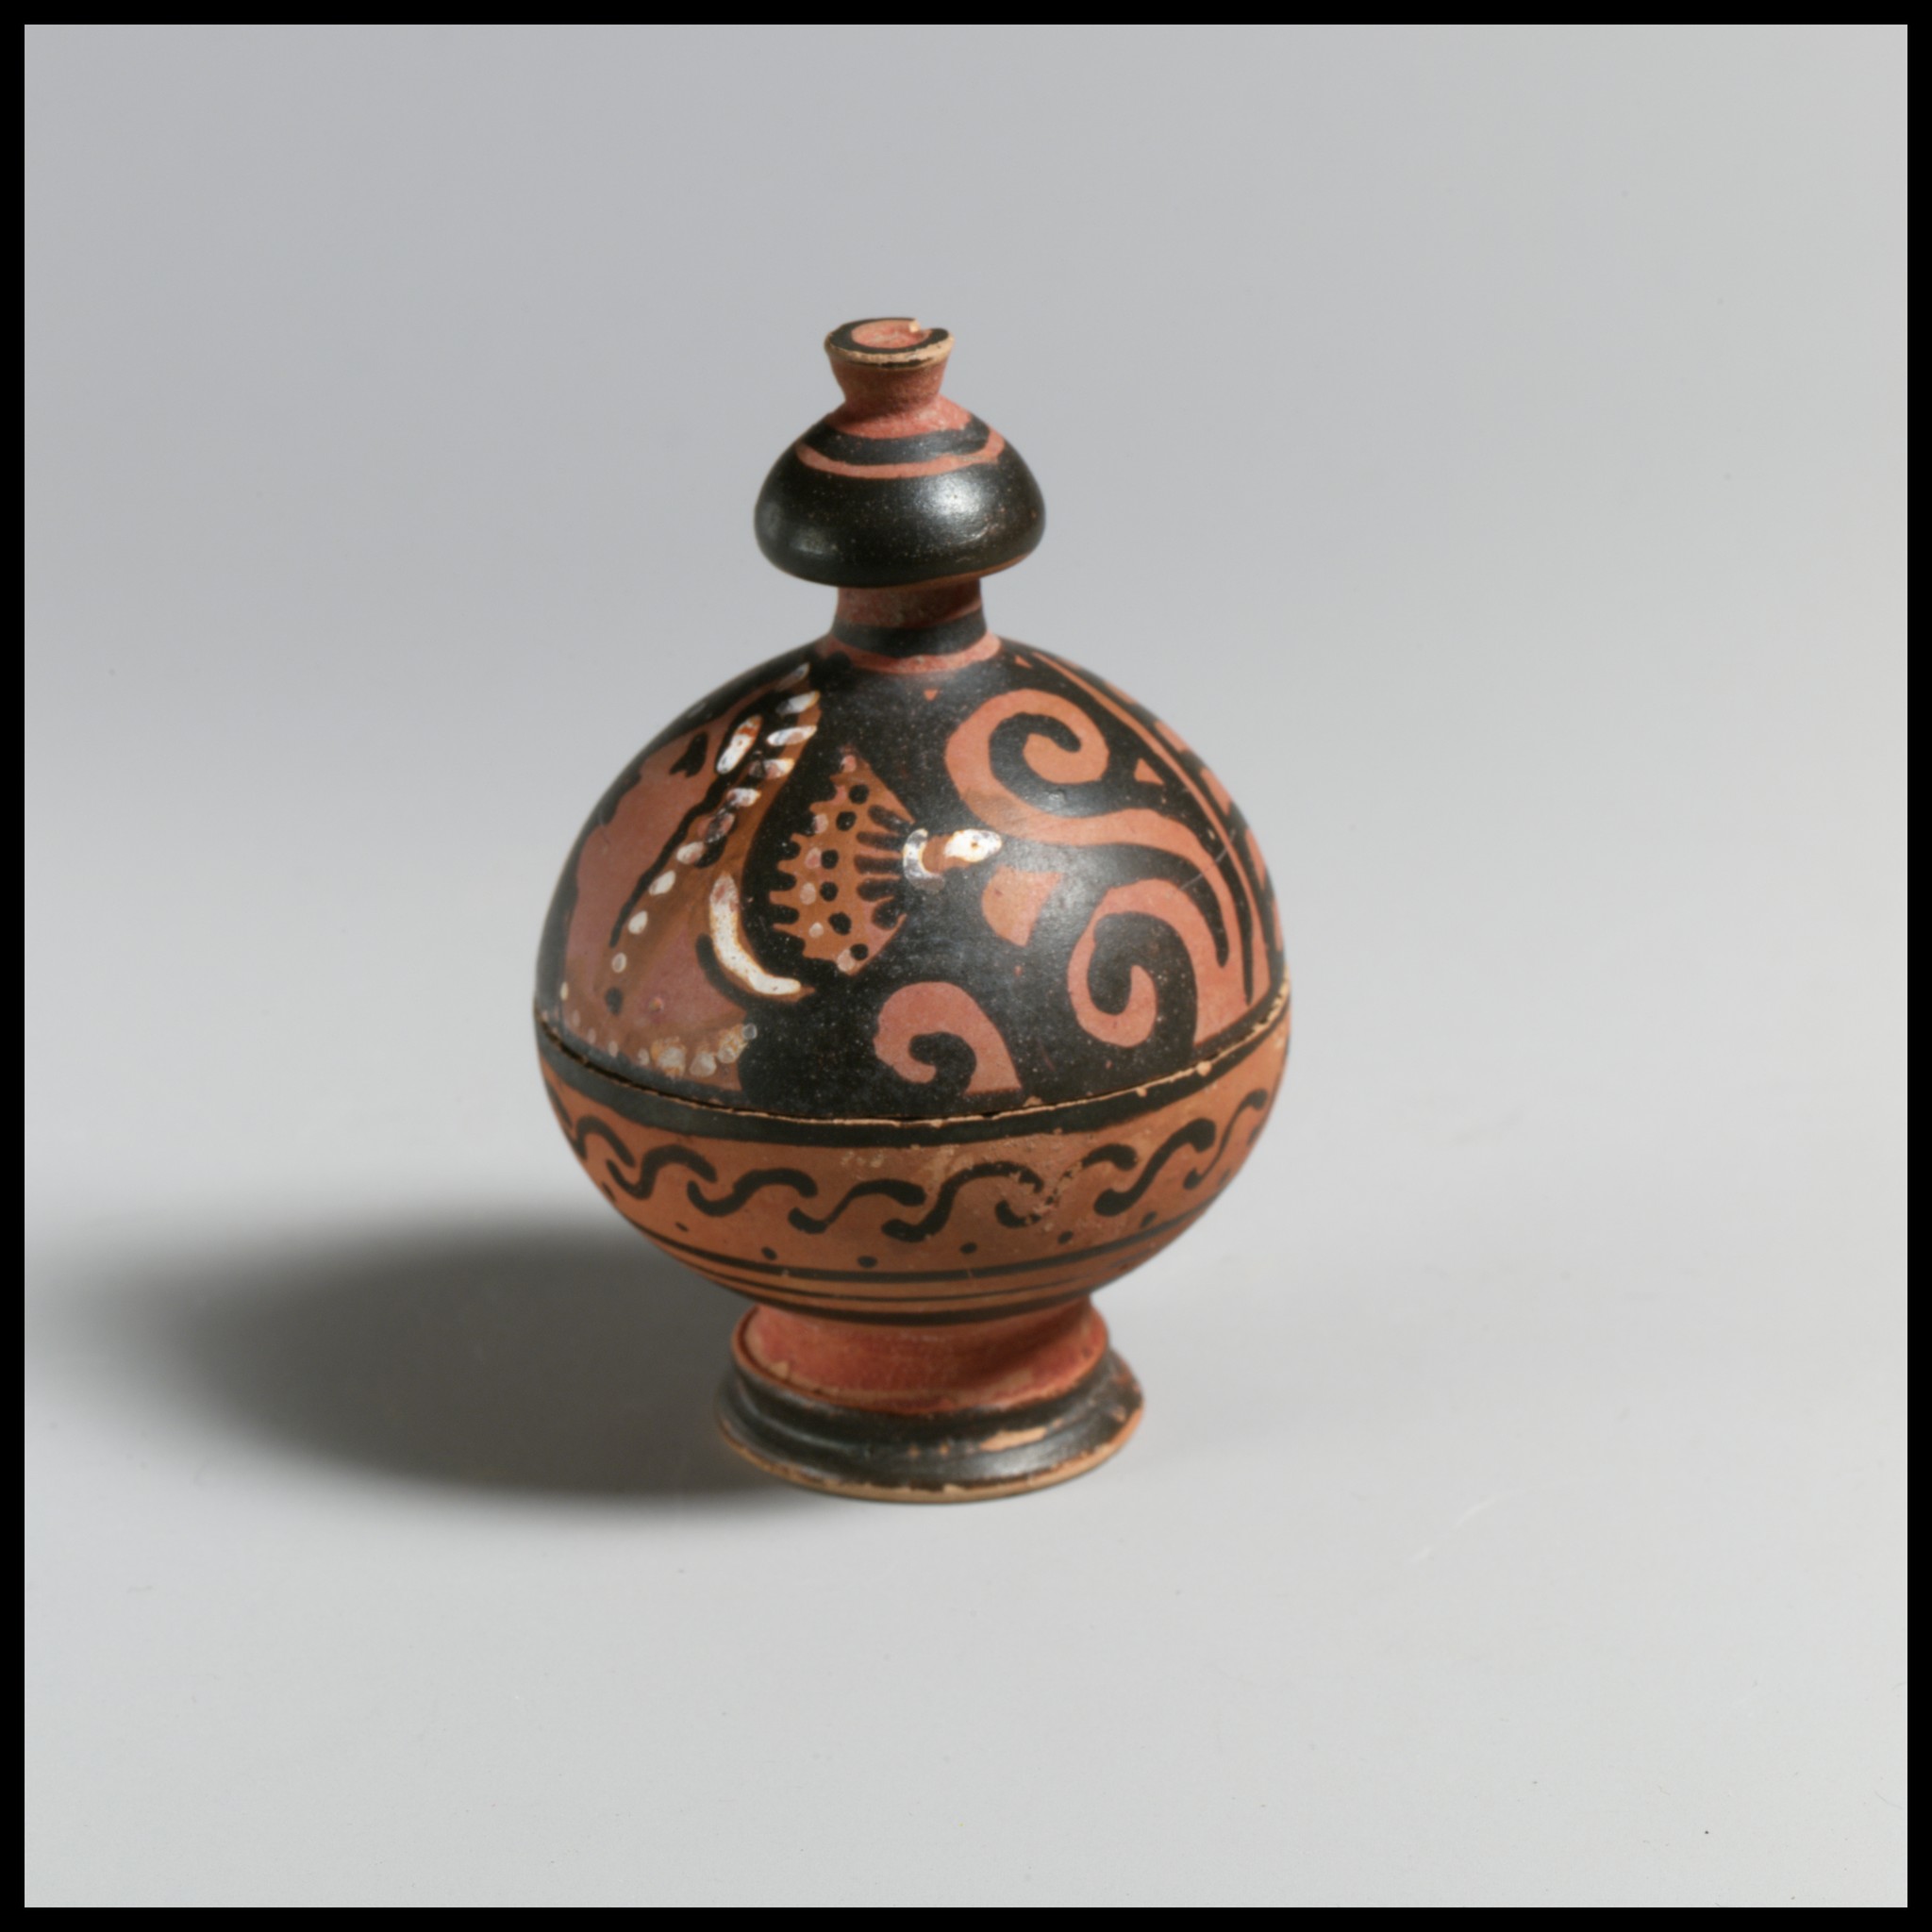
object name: pyxis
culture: greek, south italian, apulian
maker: stoke-on-trent group: "pouting lips" sub-group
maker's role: artist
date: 300 BCE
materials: terracotta